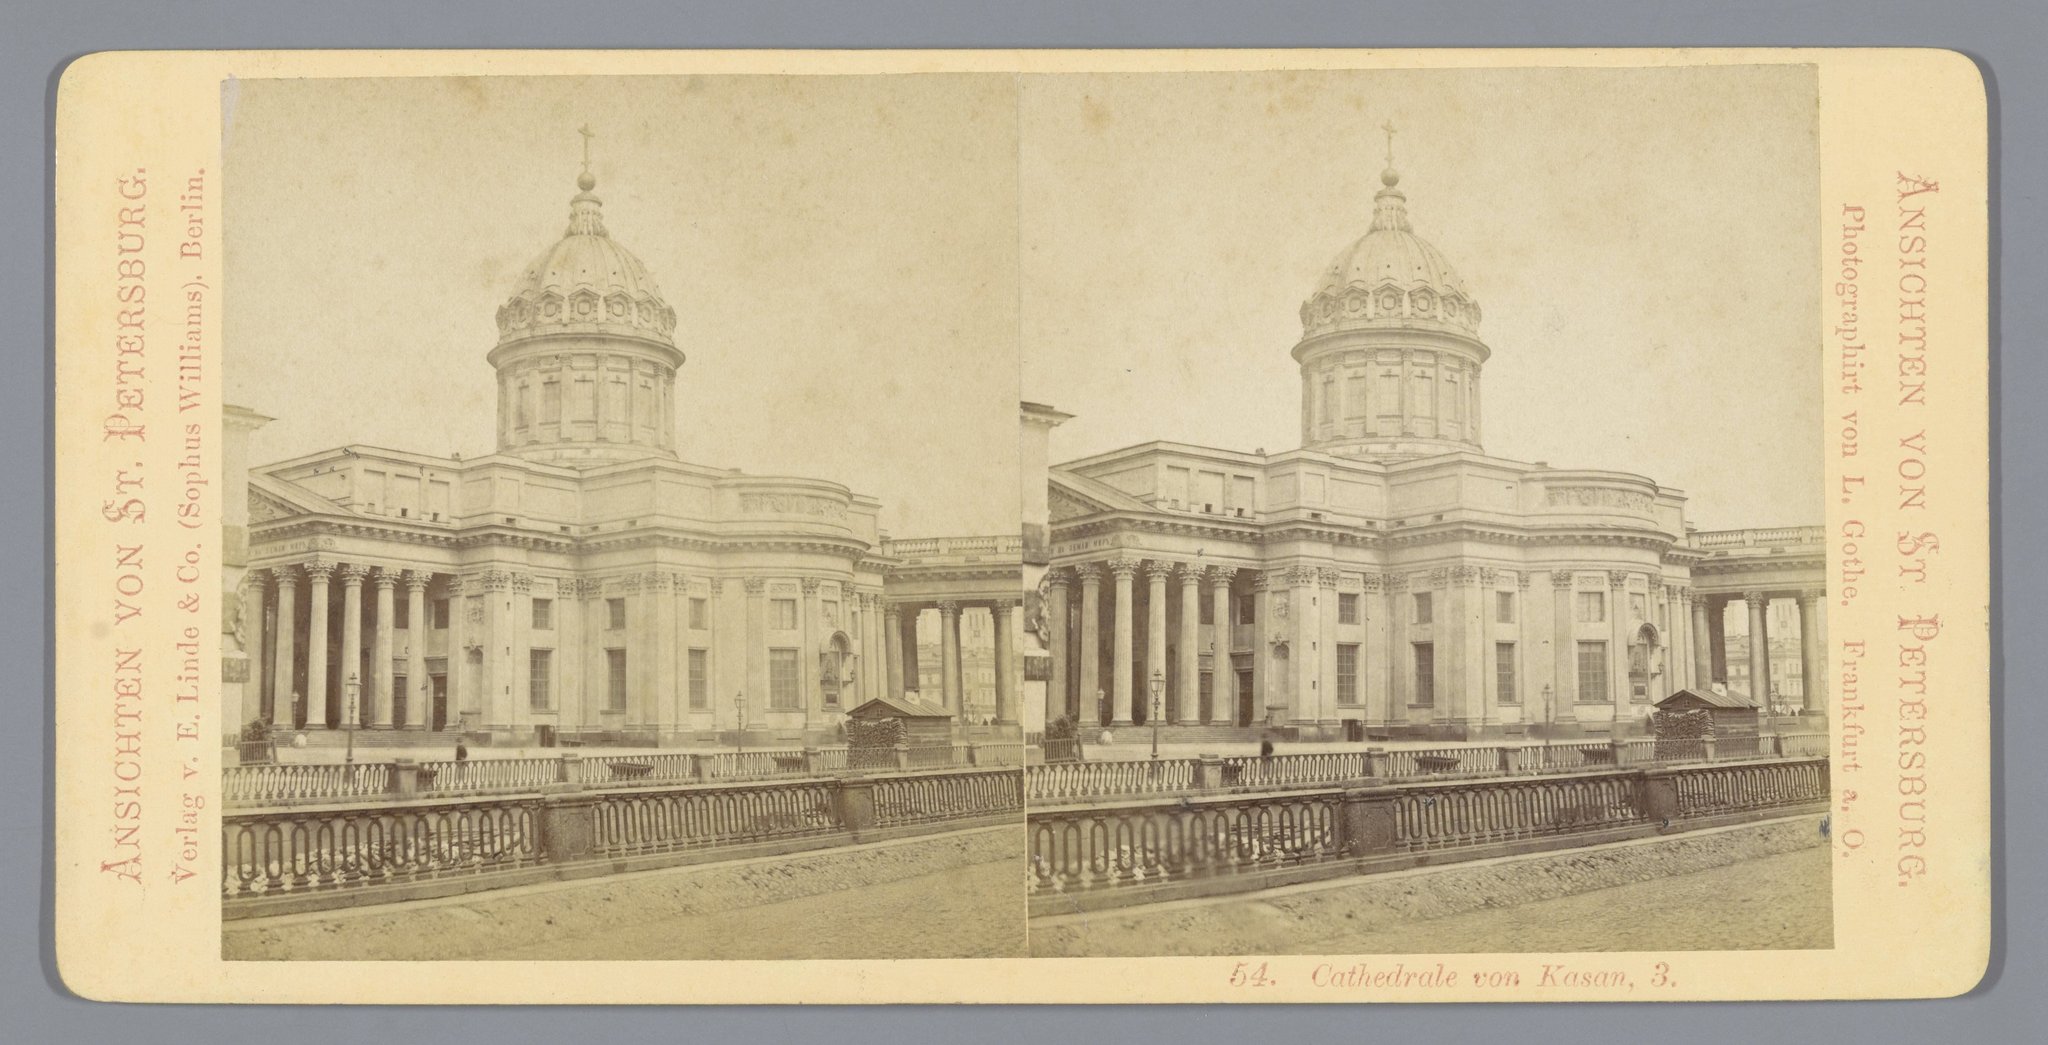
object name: stereograph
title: Cathedrale von Kasan, 3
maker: louis gothe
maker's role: fotograaf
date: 1850-1880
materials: cardboard, photographic support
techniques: albumen print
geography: sint-petersburg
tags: church (exterior), dome ~ architecture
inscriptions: inscription: ‘Ansichten von St. Petersburg.’, number: ‘54.’